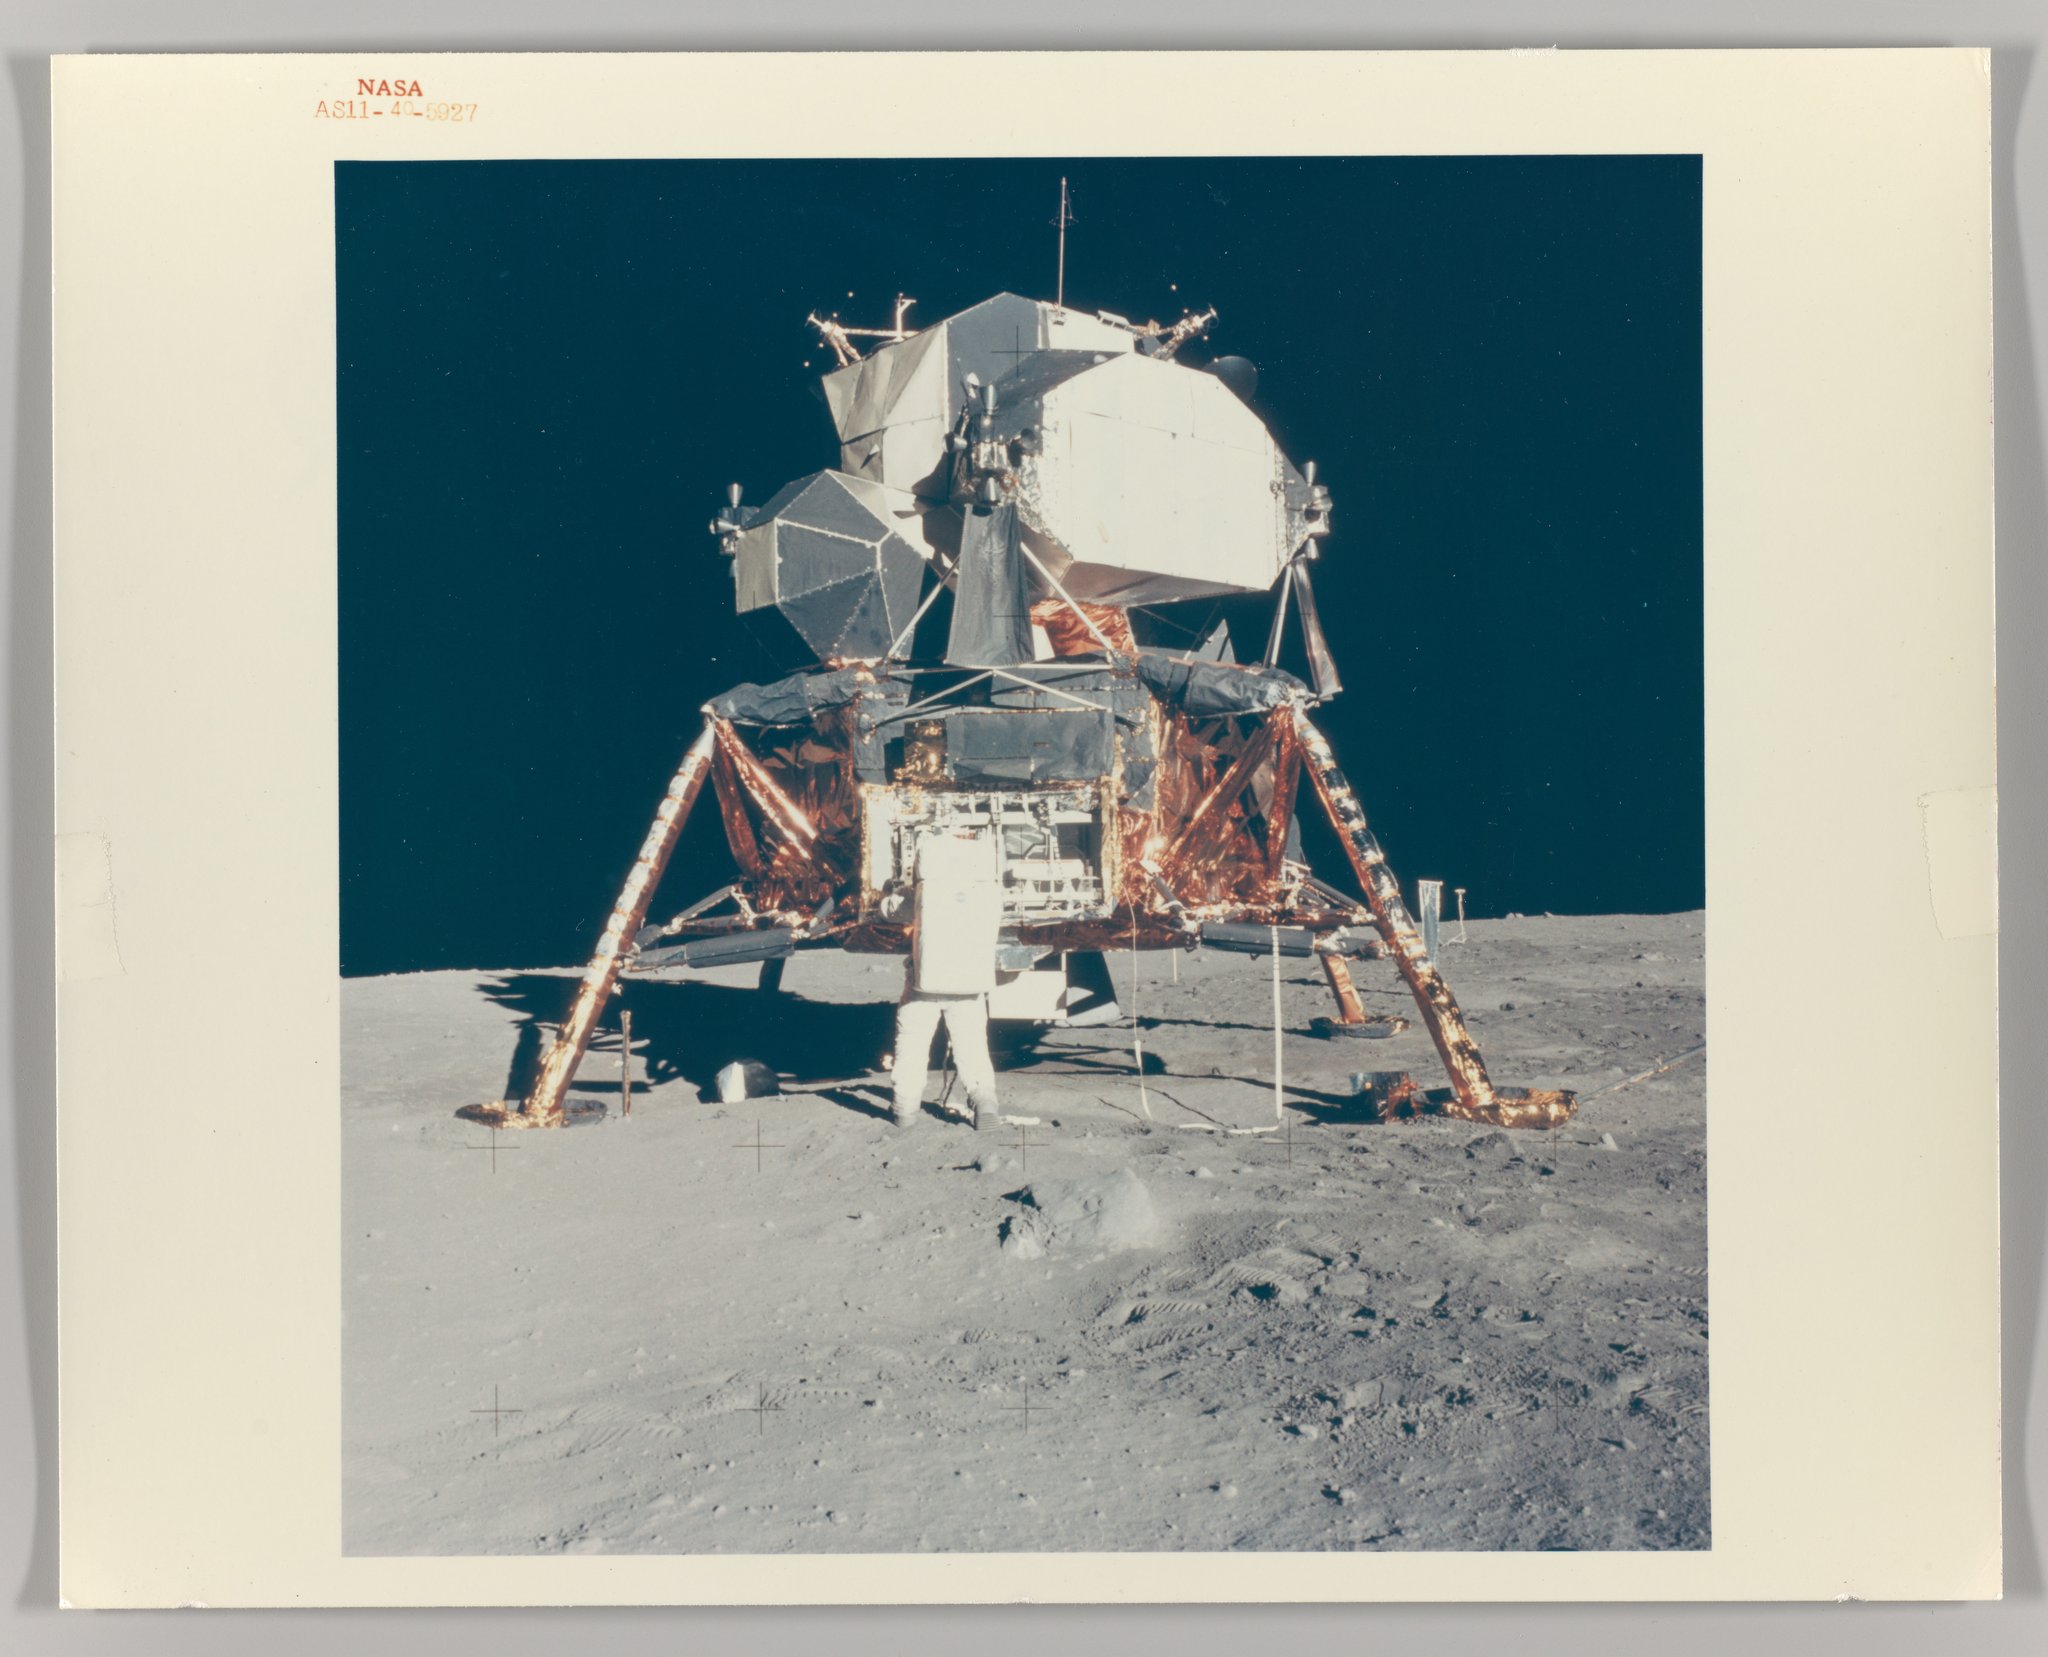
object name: photograph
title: Buzz Aldrin with Apollo 11 Lunar Module on the Moon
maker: neil armstrong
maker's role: artist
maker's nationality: american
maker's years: 1930-2012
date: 1969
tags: men,moon,astronomy